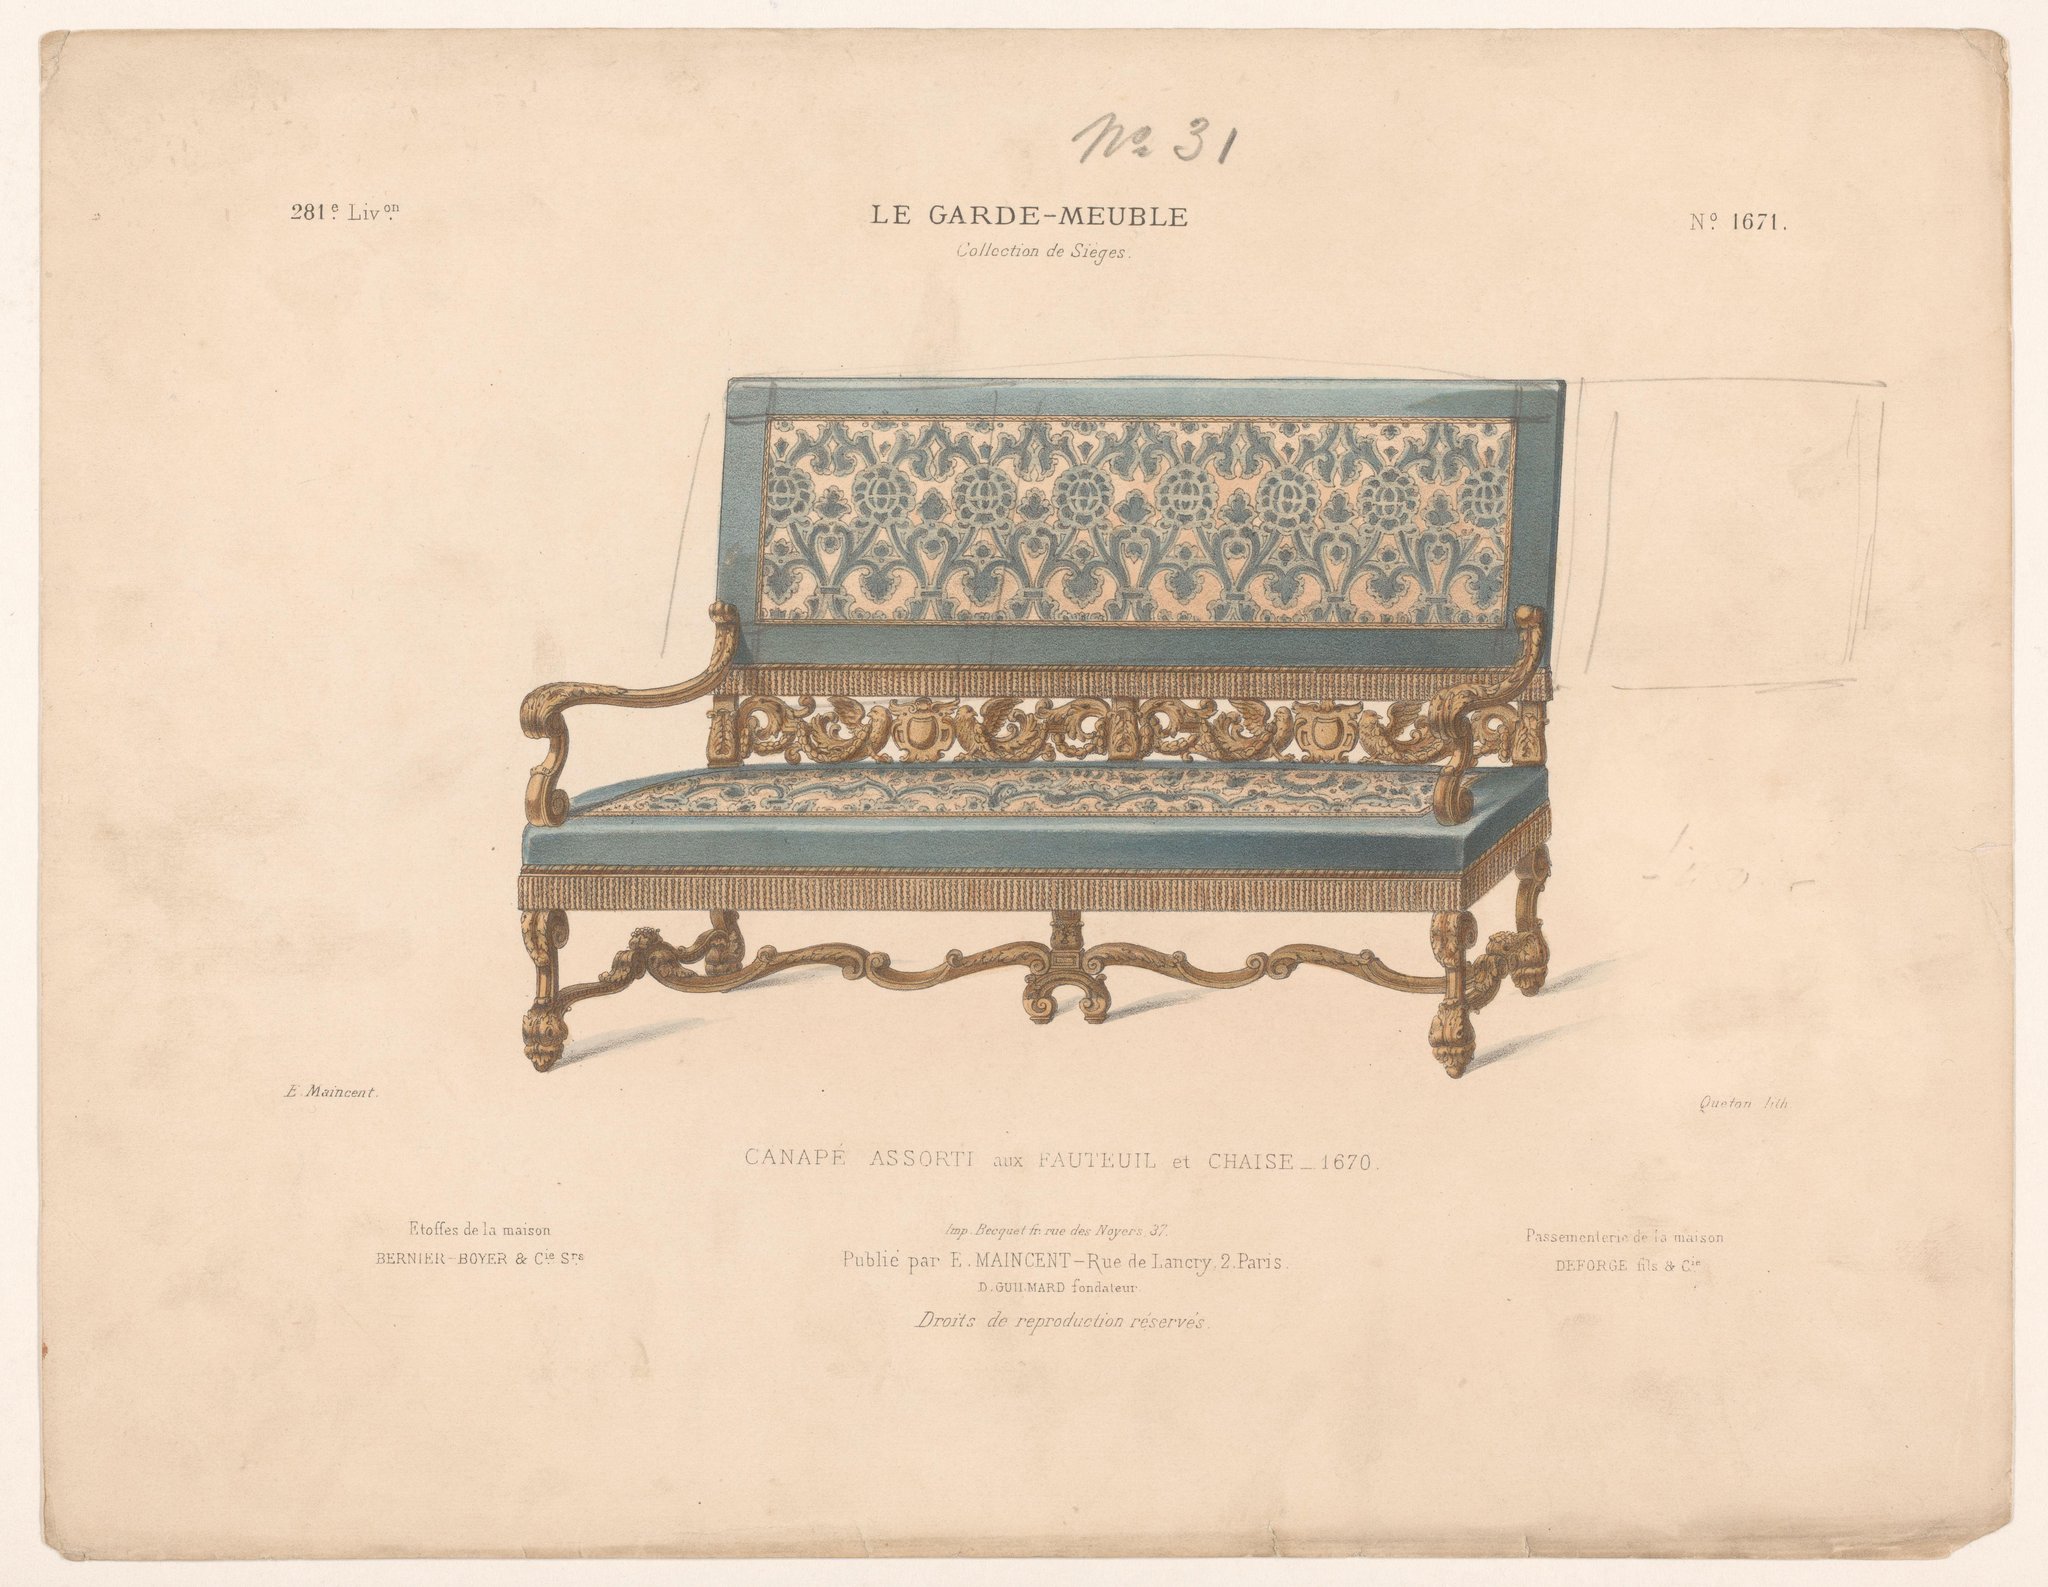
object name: print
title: Canapé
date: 1885-1895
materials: paper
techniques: hand coloring, lithograph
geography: paris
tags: seating furniture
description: Ieder Livraison in de serie Le Garde-Meuble bevat negen platen: drie 'sièges' (zitmeubels), drie 'meubles' (diverse meubels zoals tafels en kasten) en drie 'tentures' (gordijnen en draperieën).